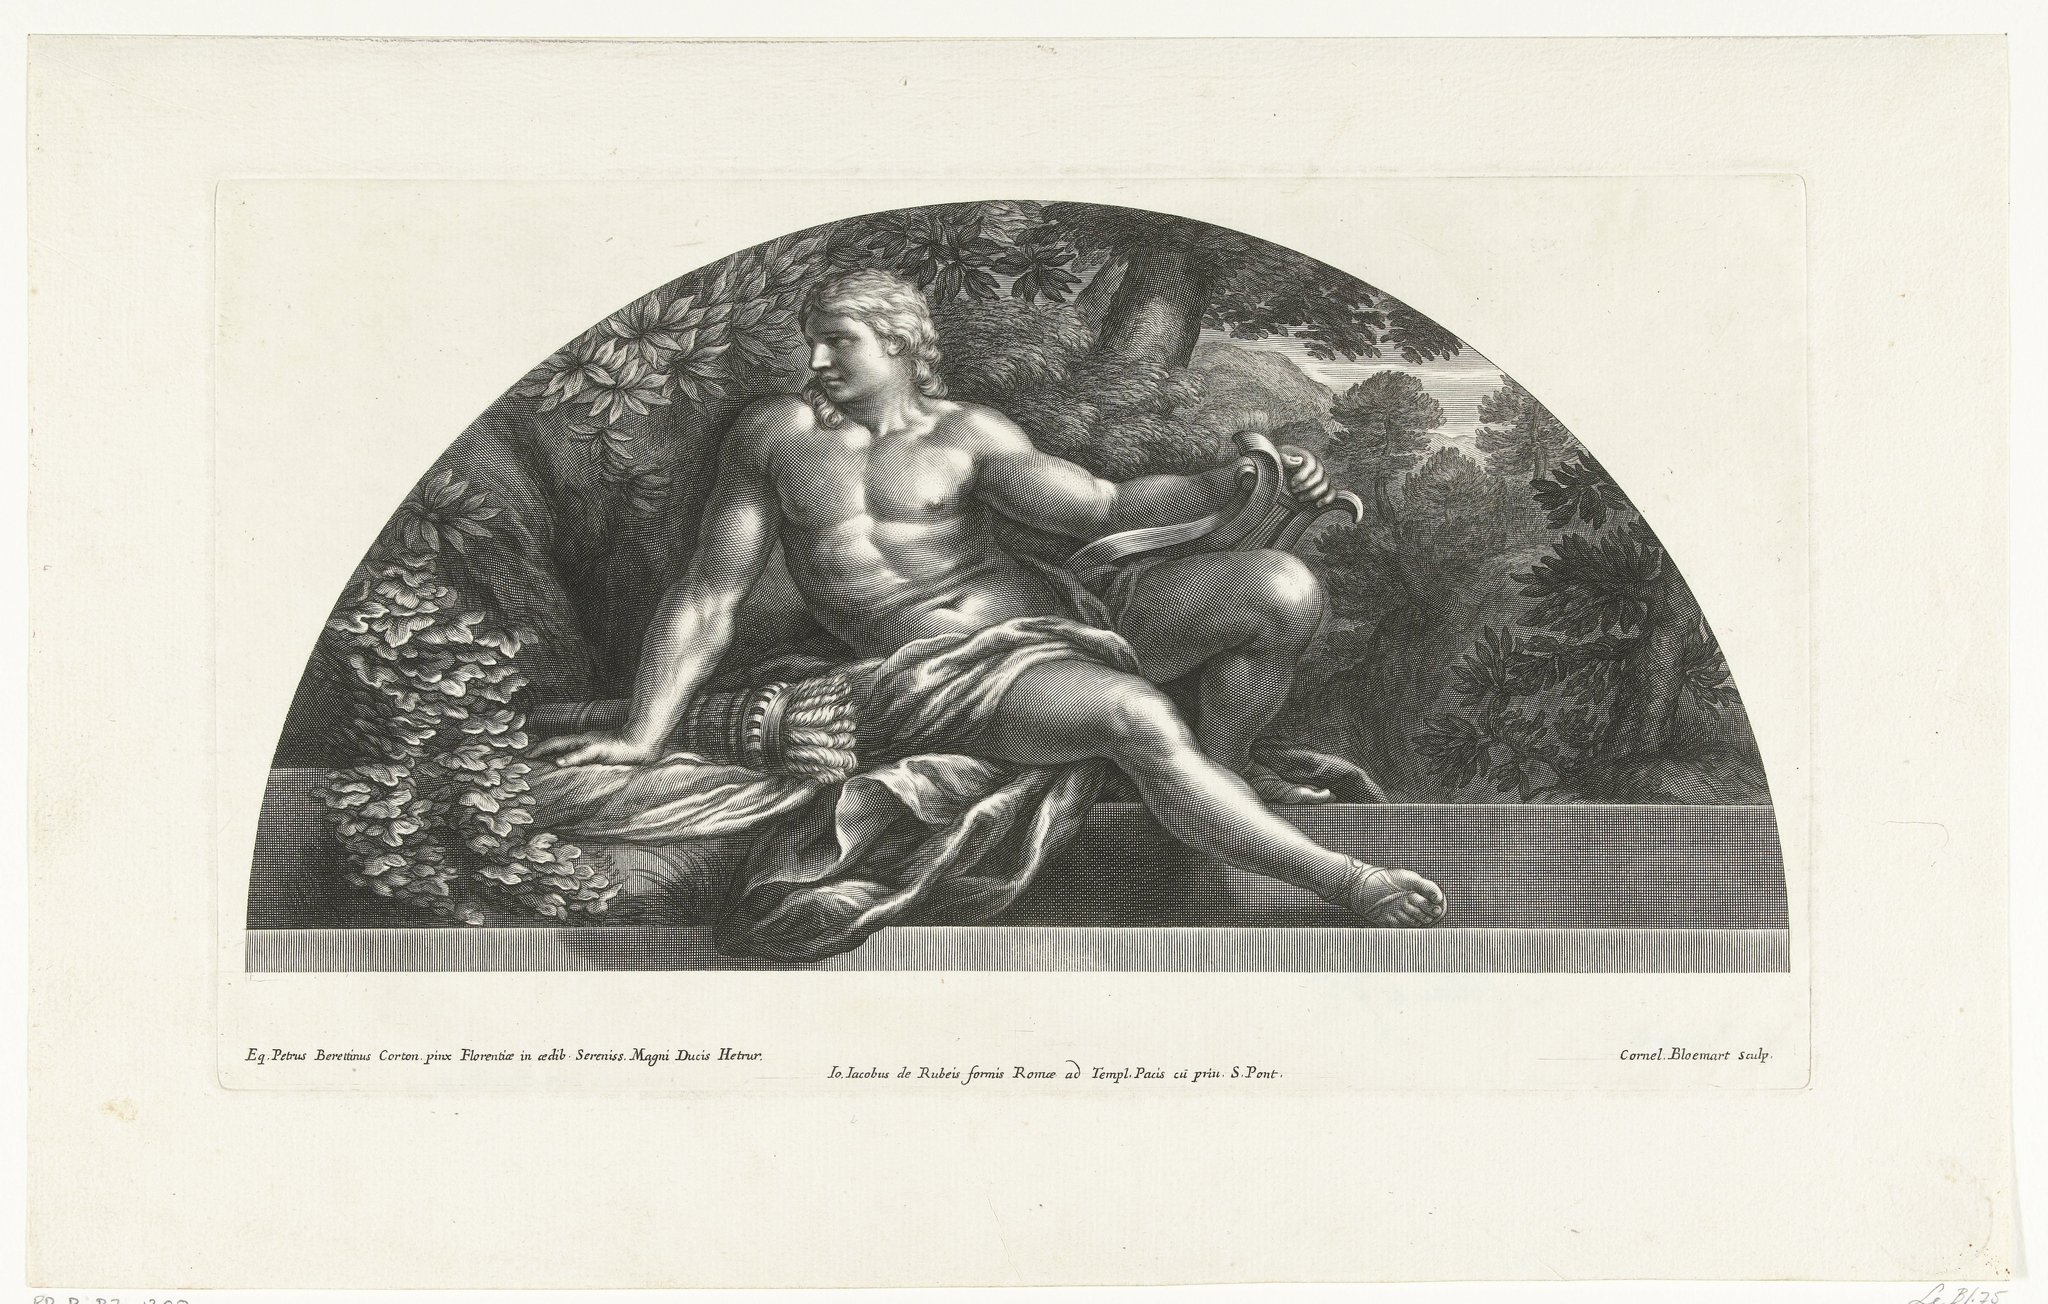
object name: print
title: Apollo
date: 1637-1692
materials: paper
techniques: engraving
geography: rome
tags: (story of) apollo (phoebus)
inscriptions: collector's mark: Lugt 240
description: Apollo zit op een stenen trap in de natuur. Als god van de boogschutters draagt hij een pijlkoker, de lier bezit hij als beschermgod van de poëzie en de muziek, en als aanvoerder van de Muzen. Prent uit een serie van vier prenten naar fresco's van Pietro da Cortona.